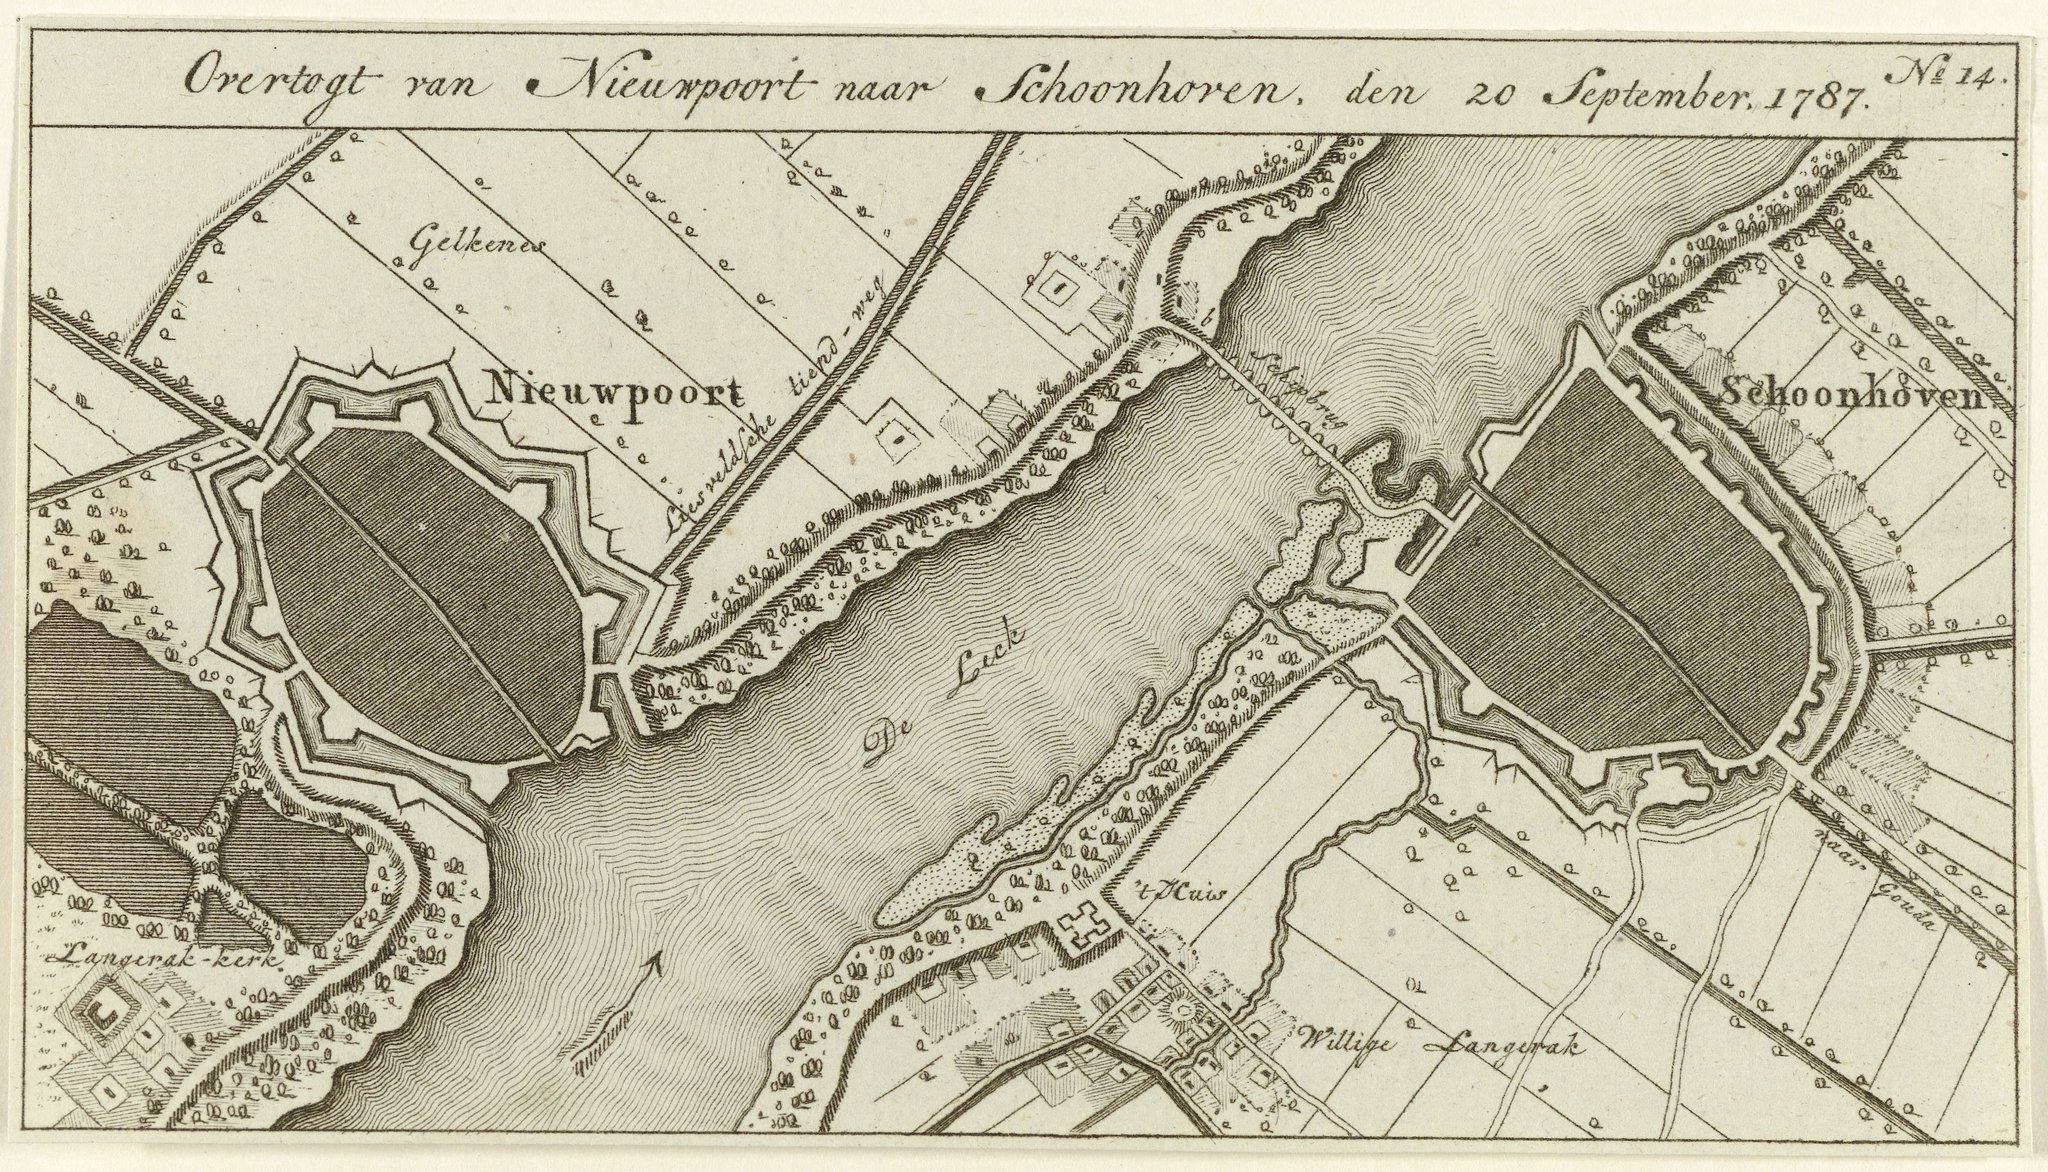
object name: book illustration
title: Oversteek van de Lek bij Schoonhoven, 1787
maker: Anonymous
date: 1790-1792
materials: paper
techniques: etching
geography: northern netherlands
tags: maps of cities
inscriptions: collector's mark: Lugt 2228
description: Kaart met de ligging van de schipbrug waarmee de Pruisische troepen bij Schoonhoven en Nieuwpoort de rivier de Lek zijn overgestoken op 20 september 1787. Onderdeel van een groep van veertien genummerde kaartjes van de kampementen van de Pruisische troepen tijdens de interventie in de Nederlanden in september 1787.